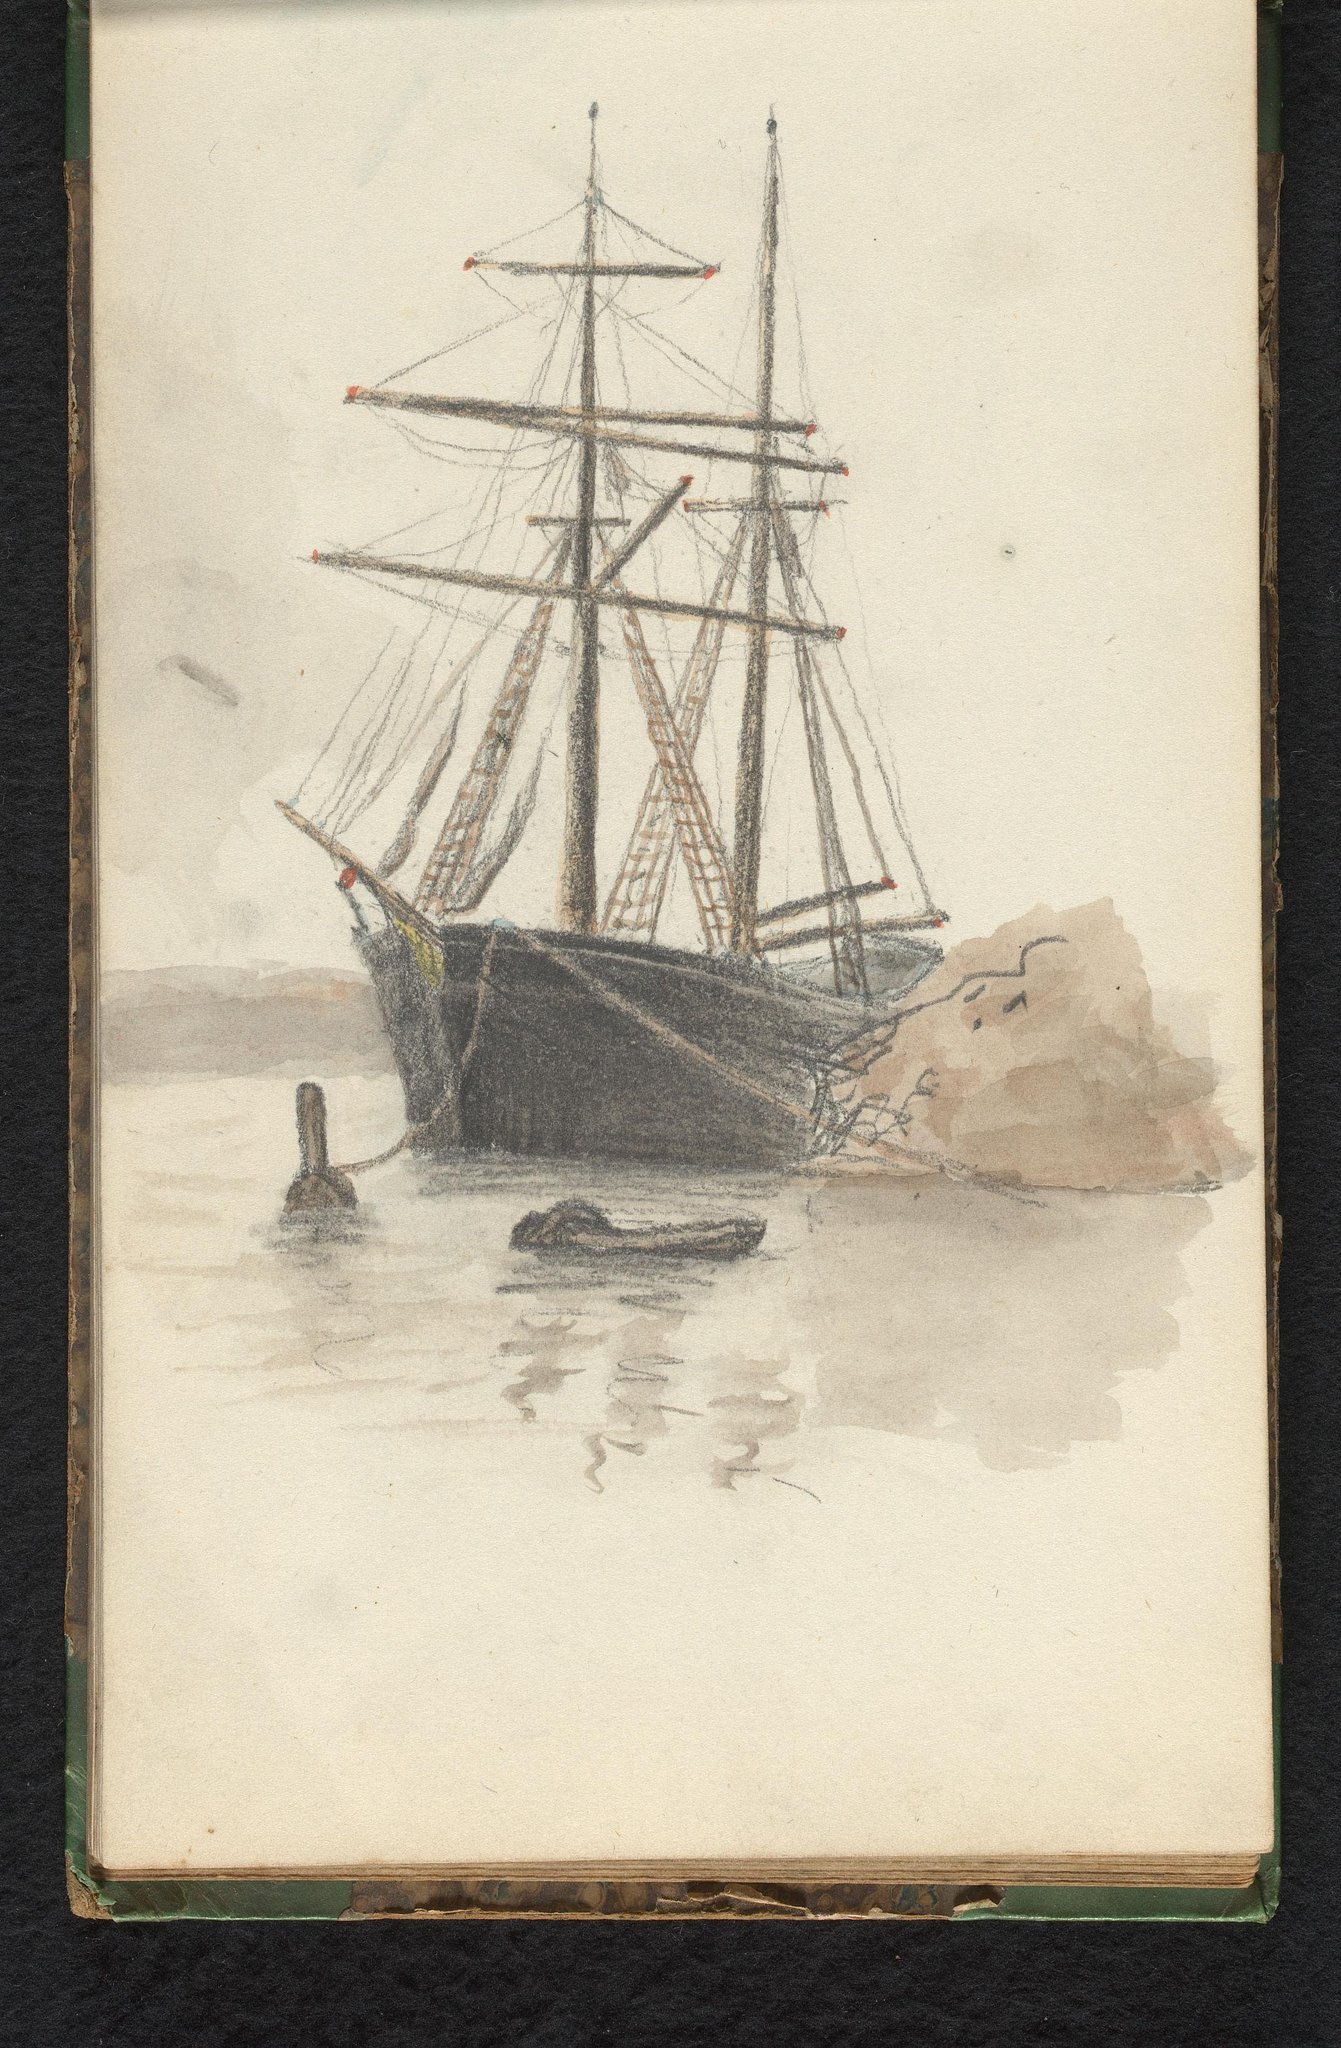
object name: sketchbook leaf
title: Schipbreuk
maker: jan bedijs tom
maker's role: draughtsman, painter, print maker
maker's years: 1813-1894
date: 1823-1894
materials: paper, pencil, watercolor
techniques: brush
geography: the hague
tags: rocky coast, shipwreck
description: Pagina 54 verso uit een schetsboek met 61 bladen.